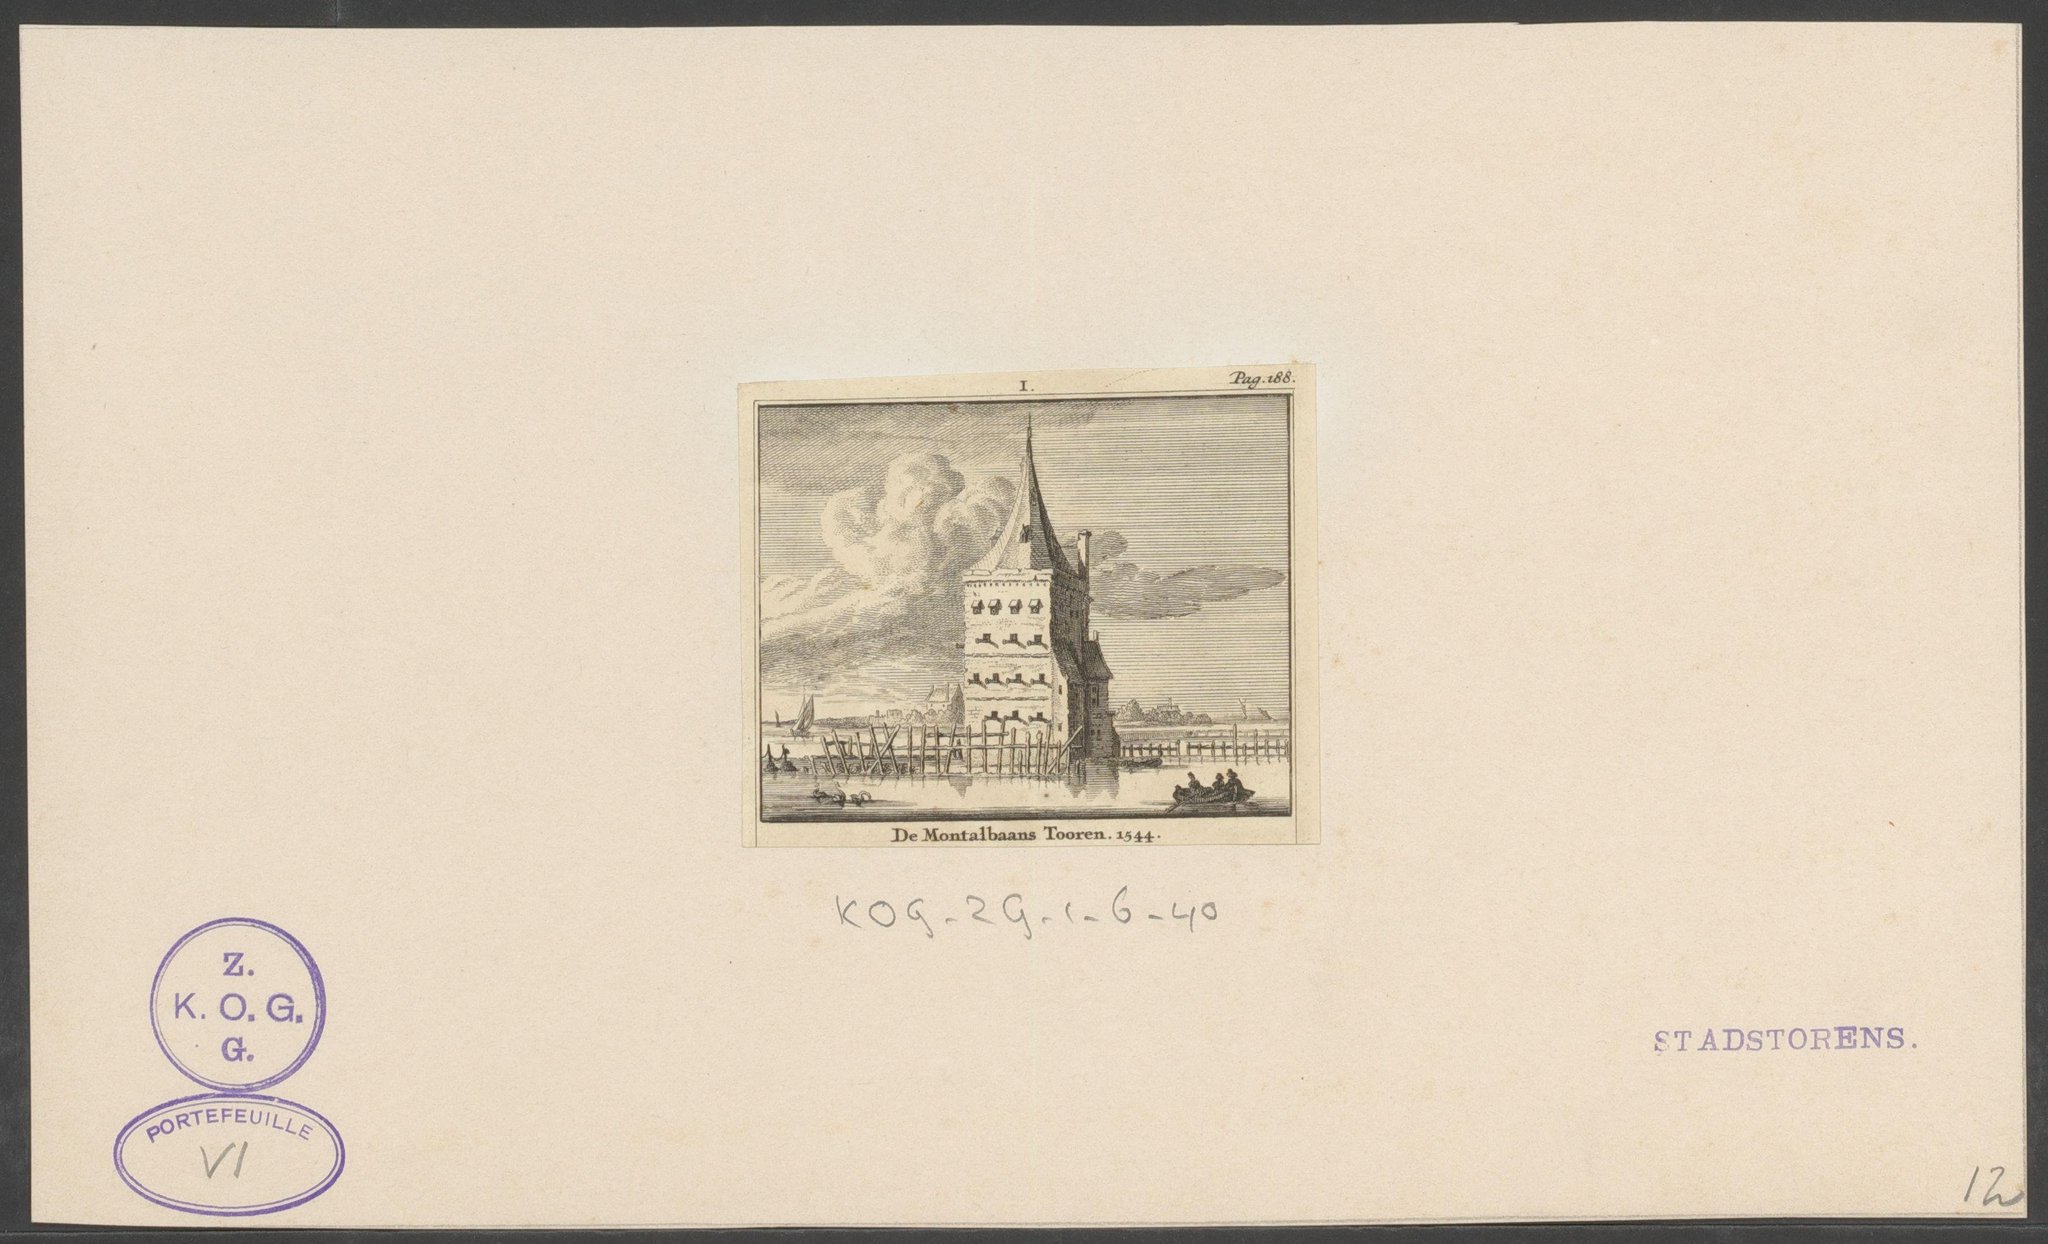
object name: print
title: De Montalbaans Tooren. 1544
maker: Anonymous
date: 1723-1738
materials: paper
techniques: etching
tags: tower, clock tower ~ monumental adornment, city-view in general; 'veduta', rowing facing backward, pulling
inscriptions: stamp, stamp, collector's mark: Lugt 1641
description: Prent waarschijnlijk uit: Willink, Daniël. Amsterdamsche Buitensingel nevens de omleggende dorpen (...). Amsterdam: Andries van Damme, 1723, p. 188-189. En in: Willink, Daniël. Daniël Willinks Amsterdamsche Buitensingel, nevens de omleggende dorpen (...). 2de druk. Amsterdam: Arendt van Huyssteen, 1738, p. 188-189.